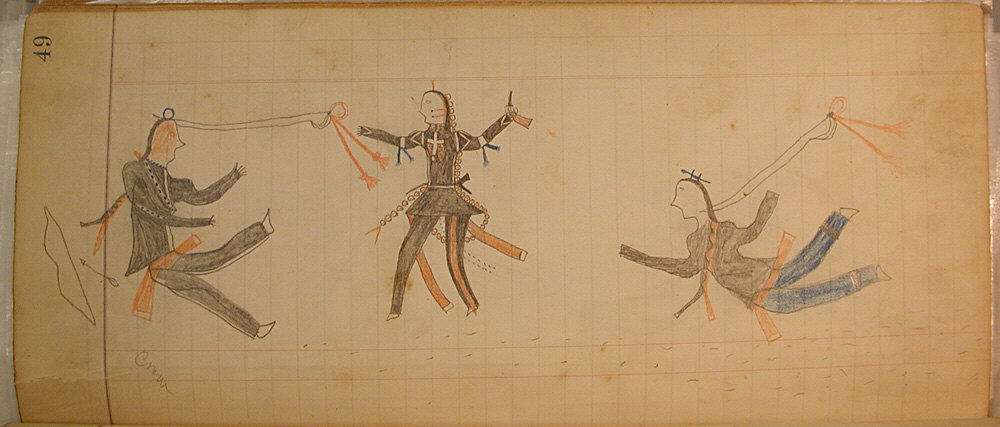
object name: drawing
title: Maffet Ledger: Three Indians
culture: cheyenne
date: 1874-1881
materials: crayon, graphite, paper, watercolor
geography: united states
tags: bow and arrow